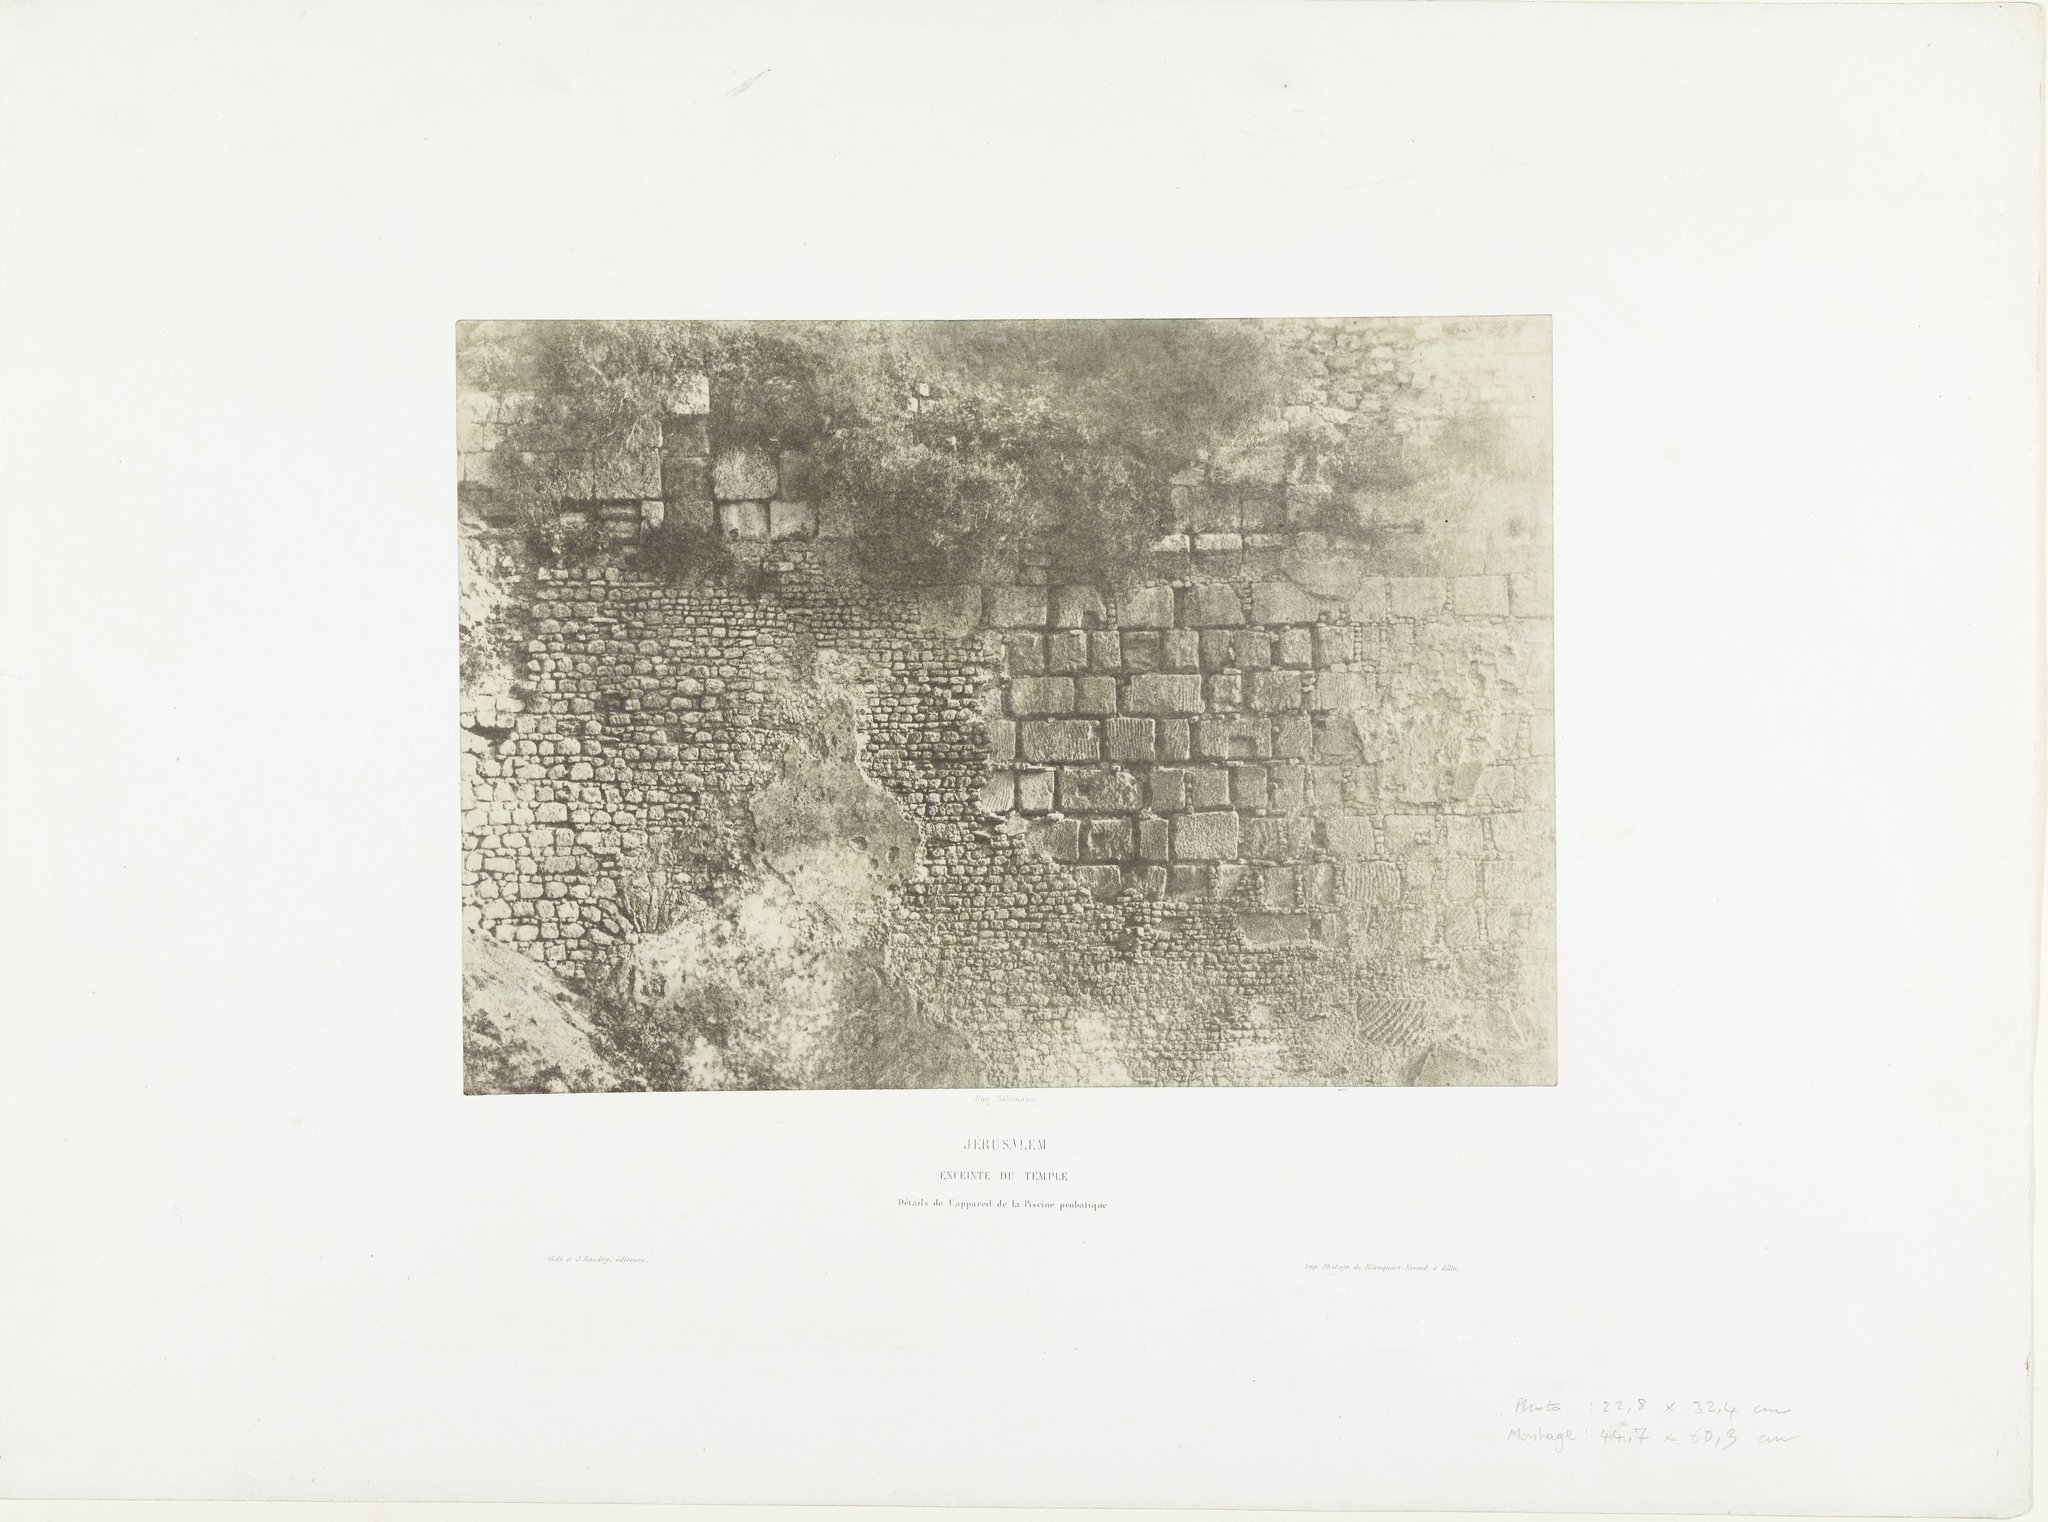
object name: photograph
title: Jérusalem/Enceinte du temple/Détails de l'appareil de la Piscine probatique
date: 1856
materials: paper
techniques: salted paper print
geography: lille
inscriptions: annotation: ‘Imp. Photogr. de Blanquart - Evrard, à Lille.’, title: ‘JÉRUSALEM ENCEINTE DU TEMPLE Détails de l'appareil de la Piscine probatique’, annotation: ‘Gide et J. Baudry, éditeurs.’, signature: ‘Aug. Salzmann’